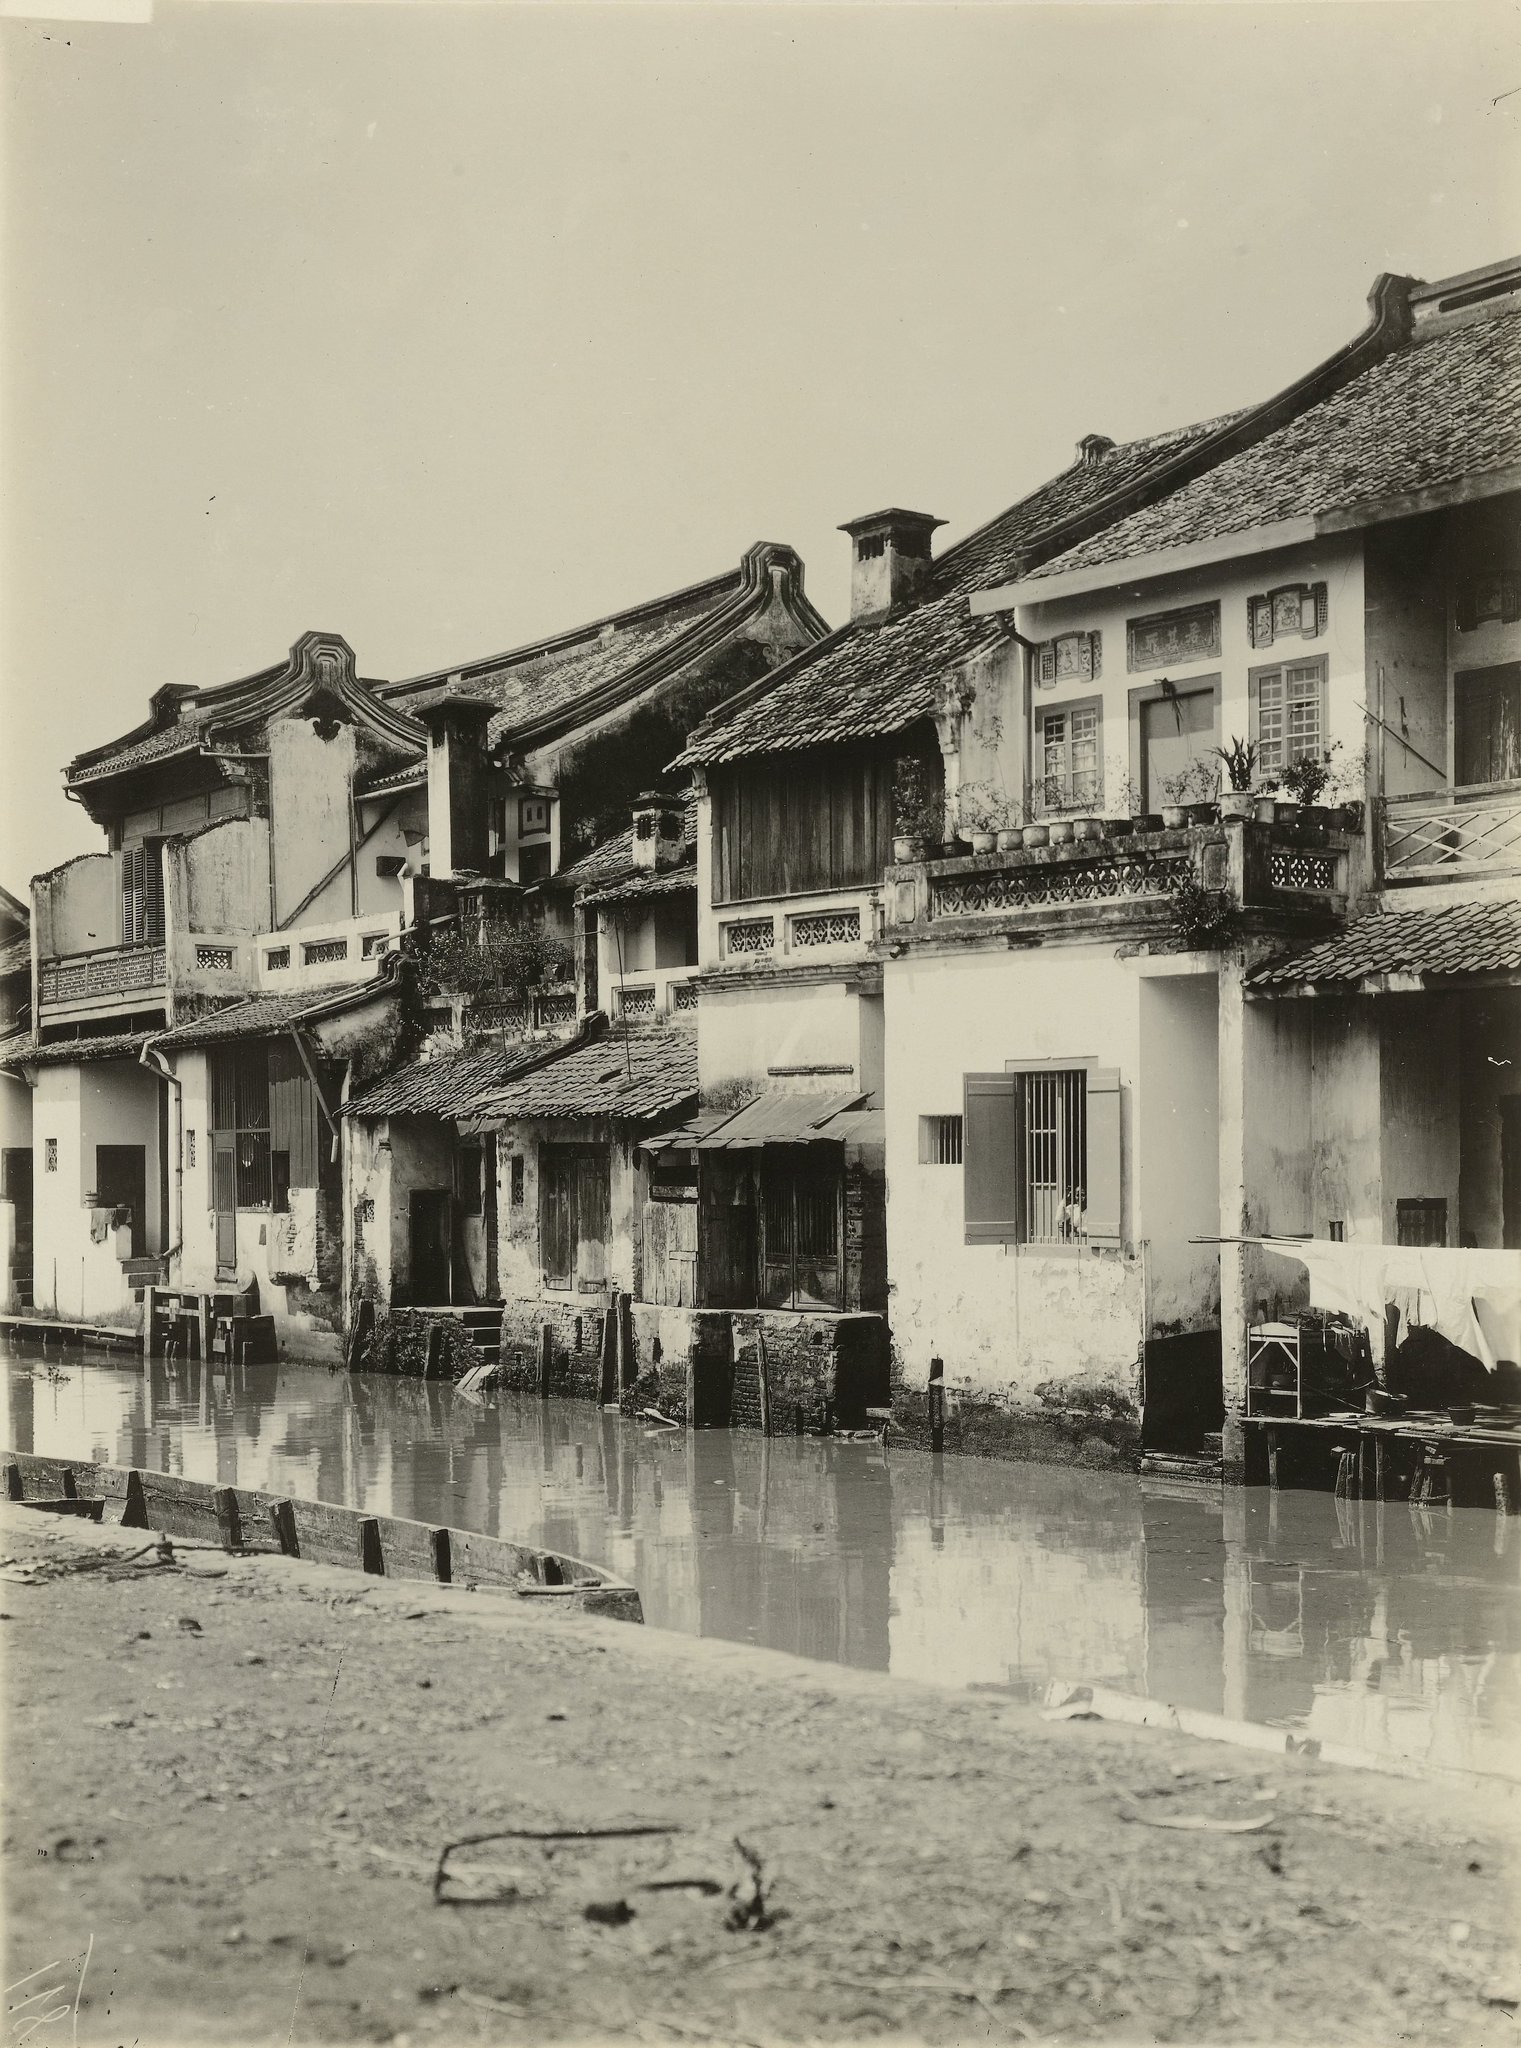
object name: photograph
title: Chinese huizen in Batavia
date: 1900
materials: paper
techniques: photography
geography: batavia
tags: dutch east indies, the, batavia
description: Eén van zes foto's (zwart-wit) van Nederlandse gebouwen en de Chinese wijk in Batavia (Jakarta), Nederlands-Indië. Merken; achterzijde: stempel: 'chef van den oudheidkundige dienst' en wapen van Nederland. Opmerking: zie NG-1009-A t/m F.